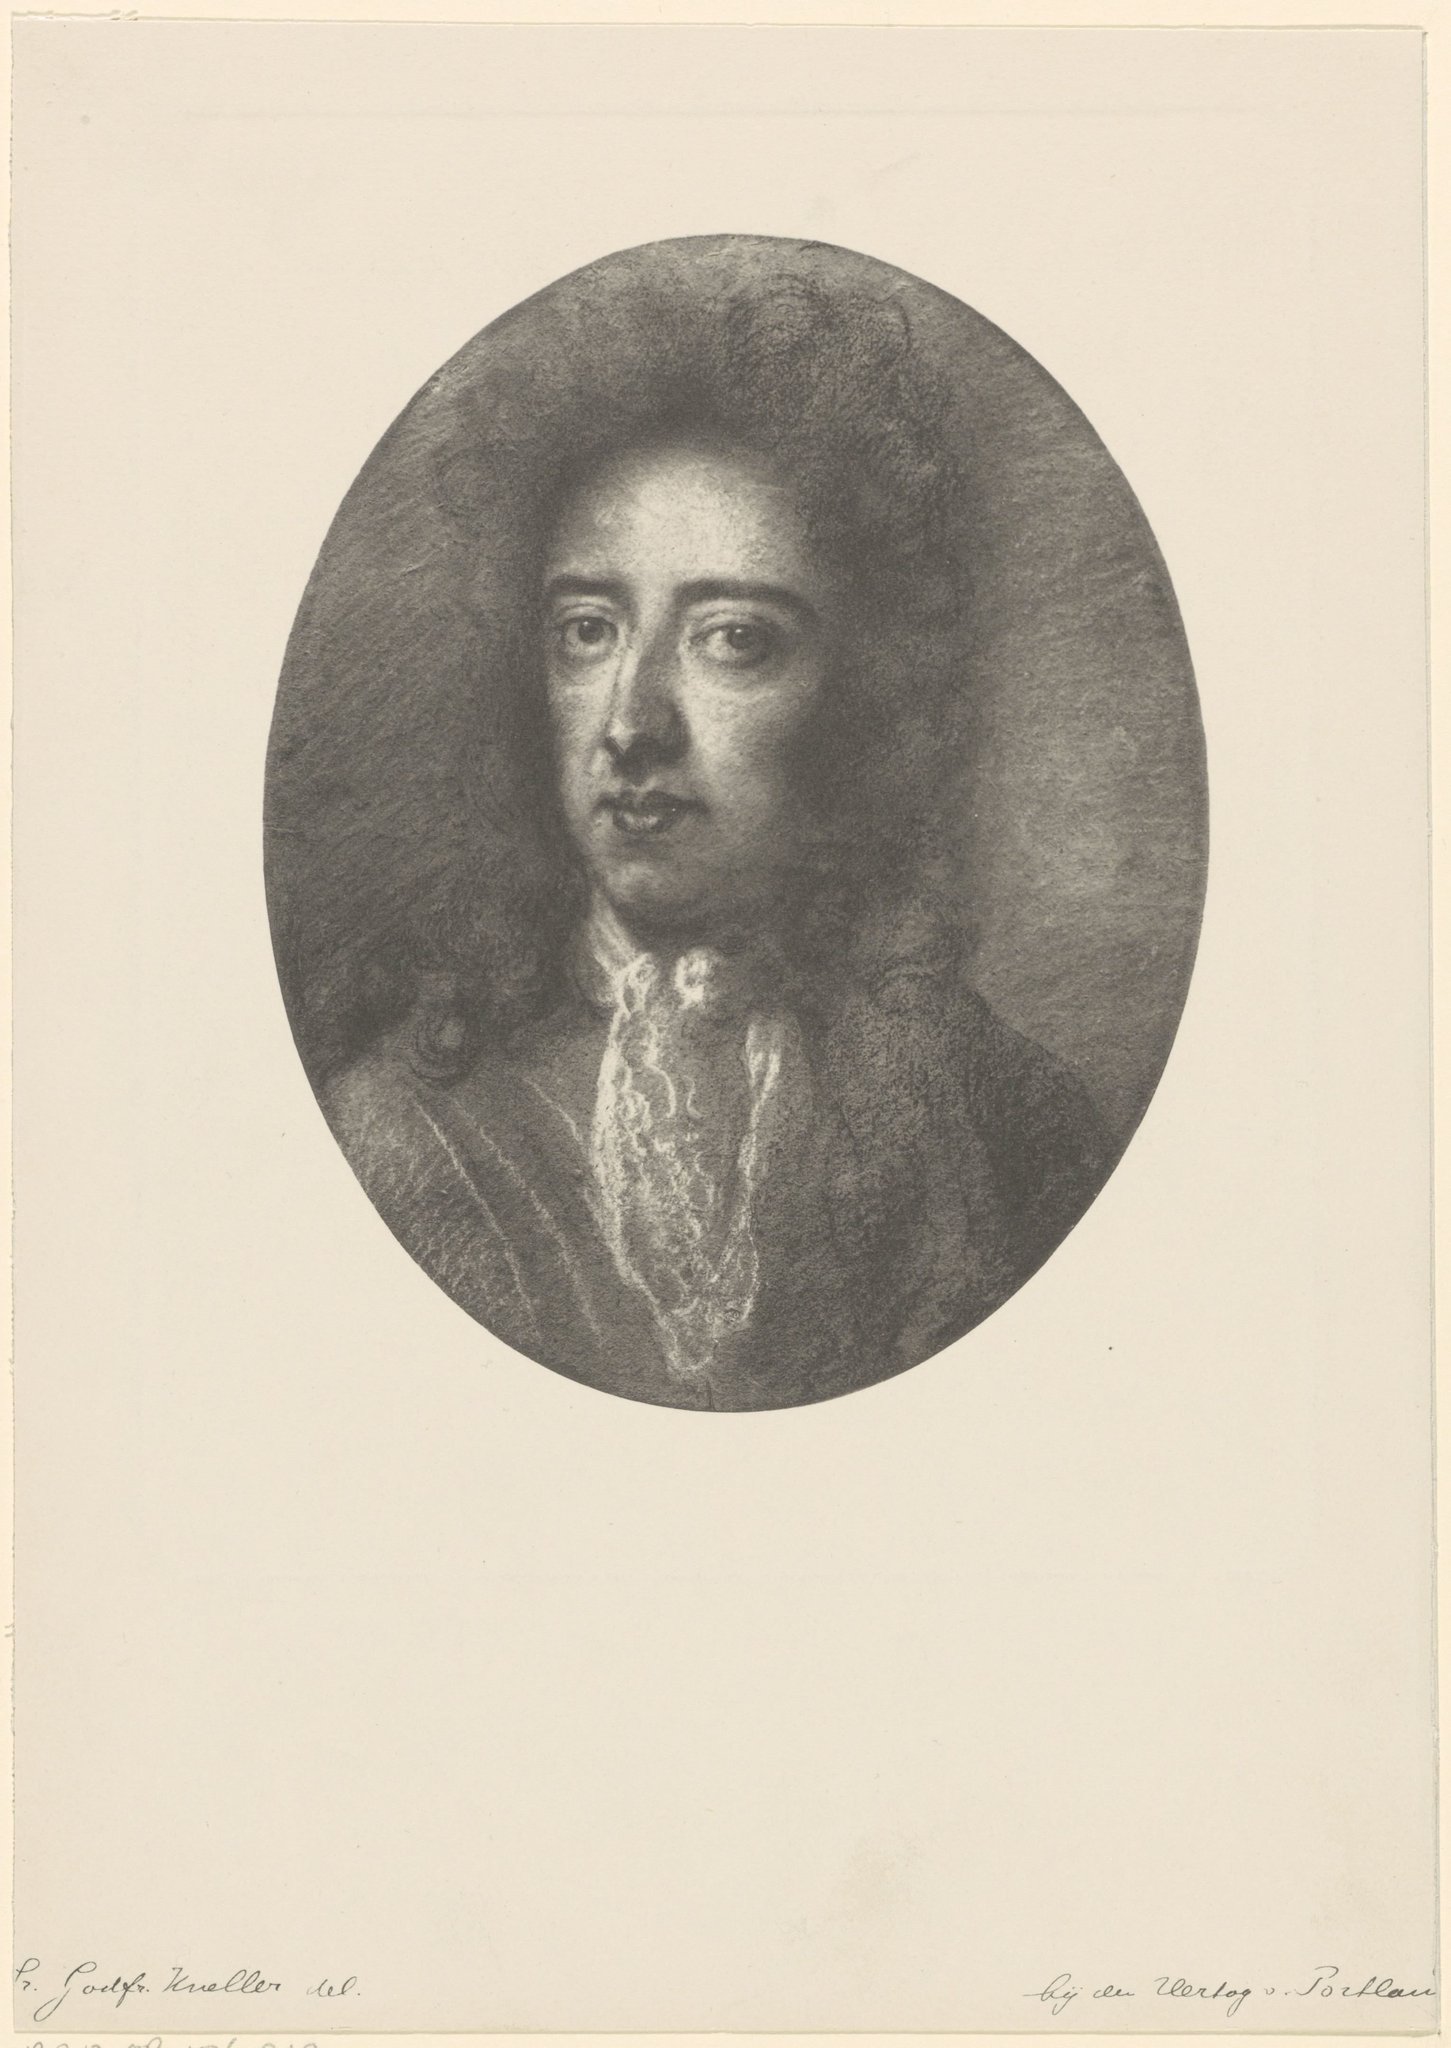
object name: photomechanical print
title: Portret van Willem III, prins van Oranje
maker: Anonymous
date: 1850-1949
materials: paper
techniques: photograph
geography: netherlands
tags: the hague, william iii (prince of orange and king of england, scotland, and ireland)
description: De hier vermelde titel verwijst naar de hoogst verkregen titel van de geportretteerde, niet per se naar de titel die de geportretteerde op deze voorstelling draagt.